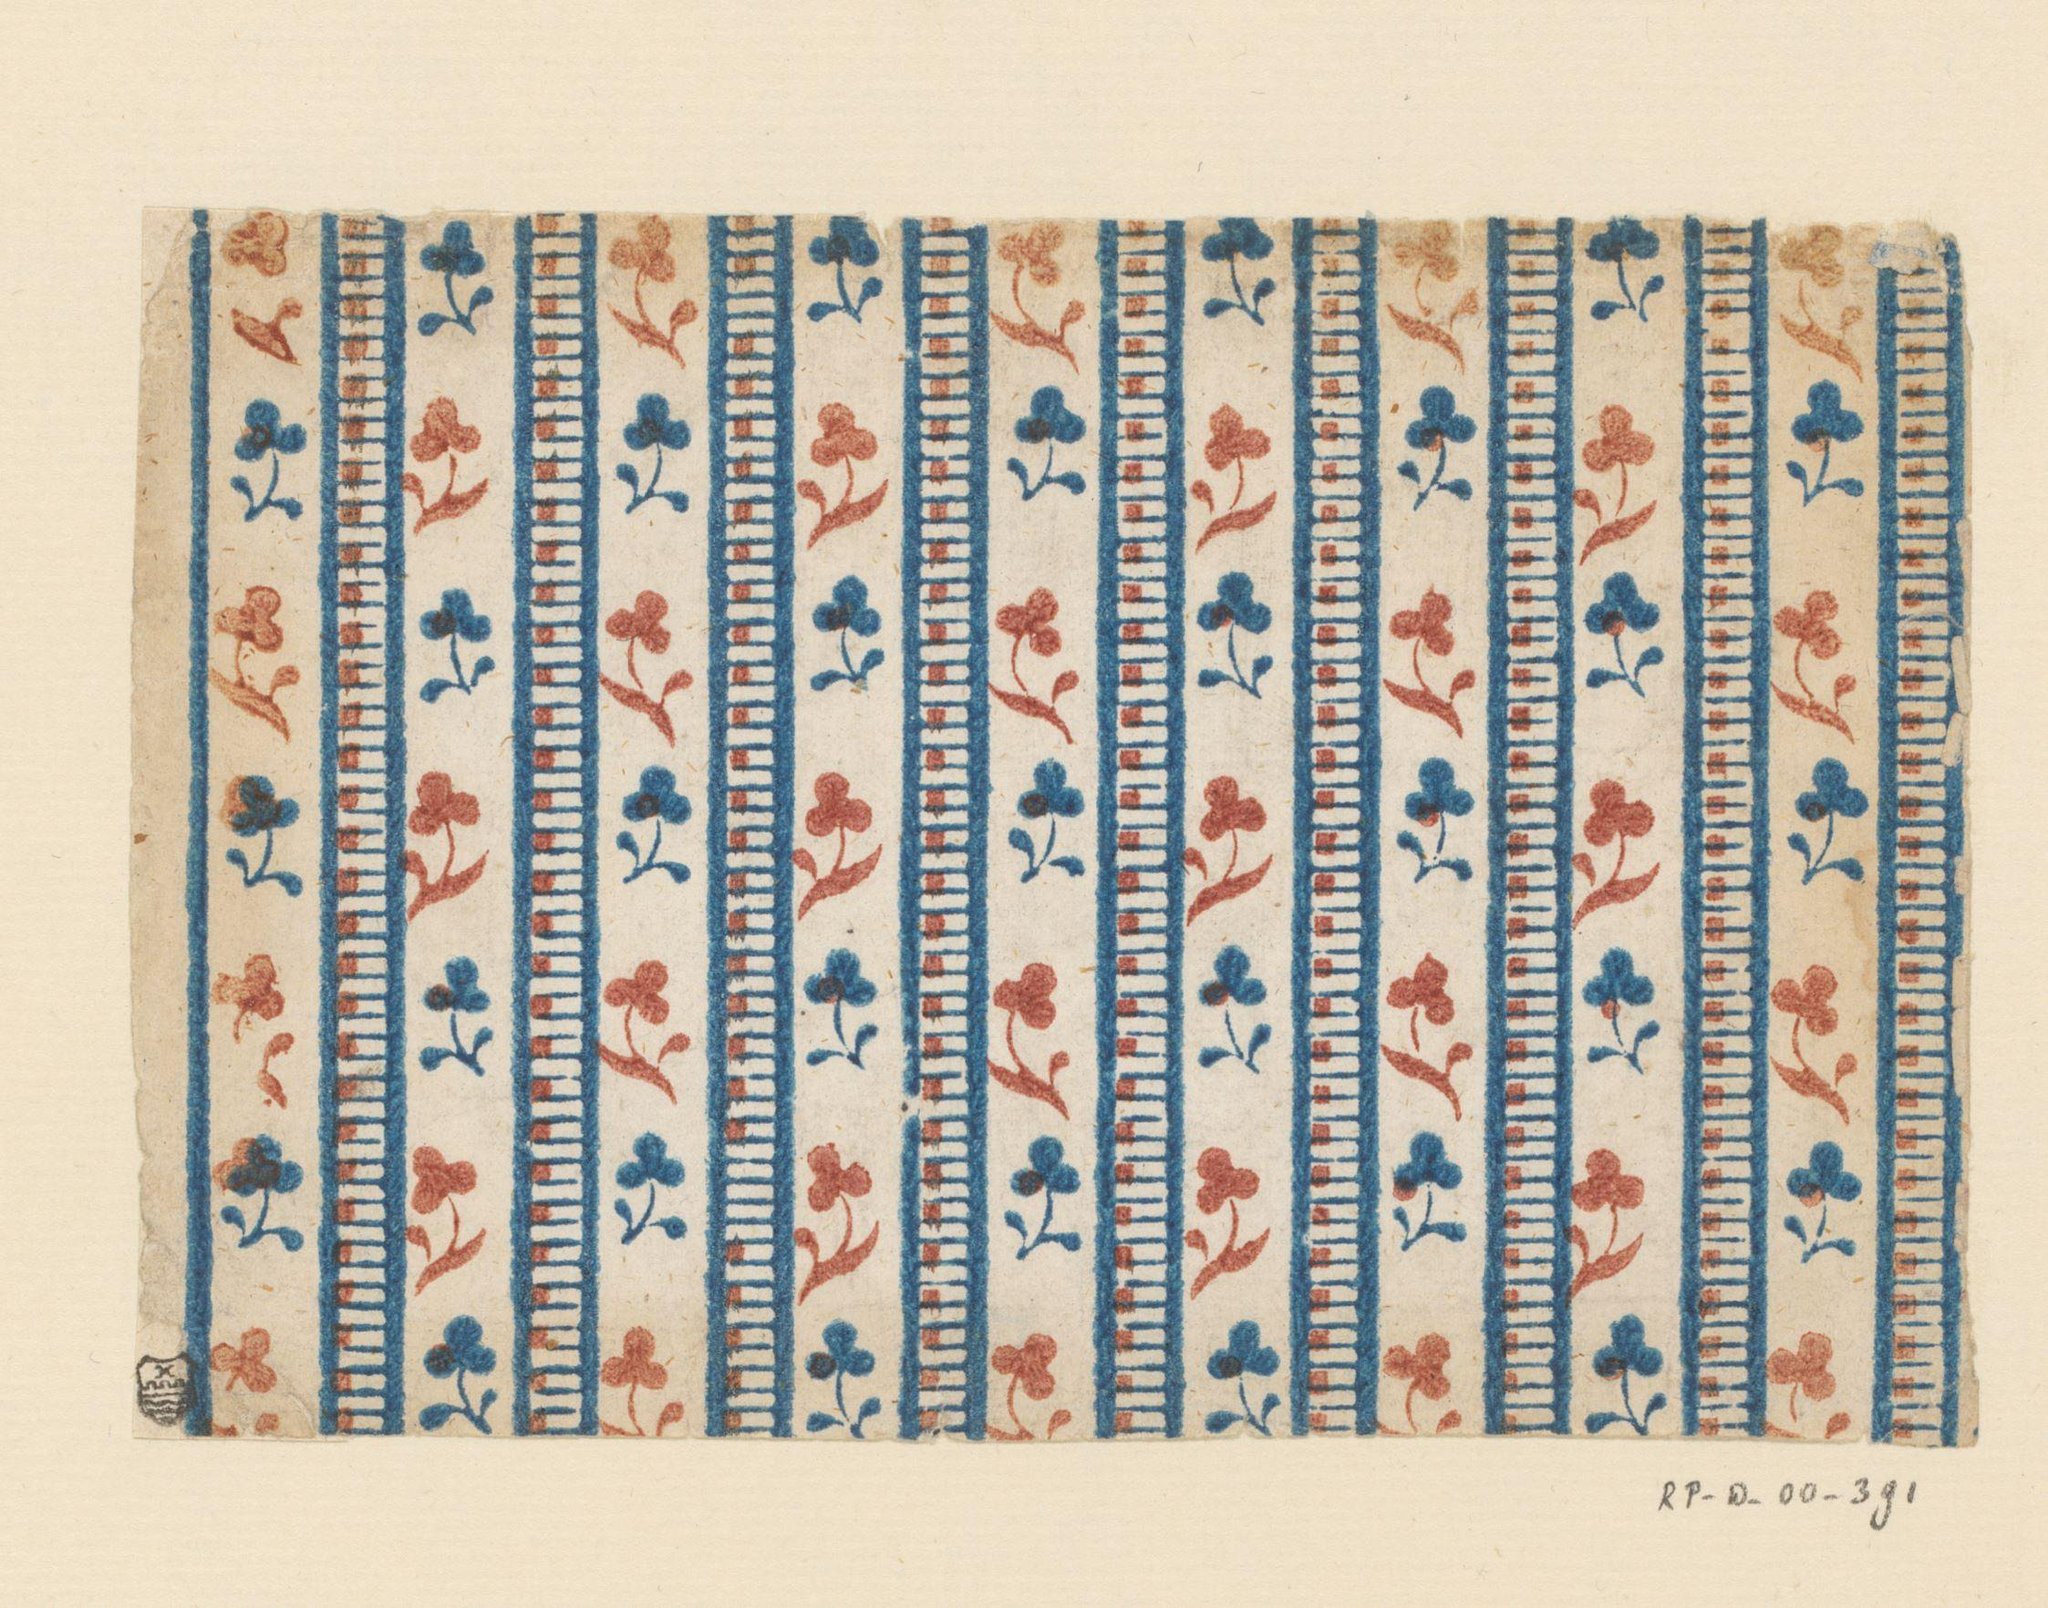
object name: printed paper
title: Blad met banenpatroon van bloemtakje en sierlijst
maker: Anonymous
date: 1700-1850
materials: paper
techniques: printing block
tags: ornament derived from plant forms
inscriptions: collector's mark: Lugt 2760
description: Blad met banenpatroon van bloemtakje en van sierlijst met lijnen met streepje en blokje.